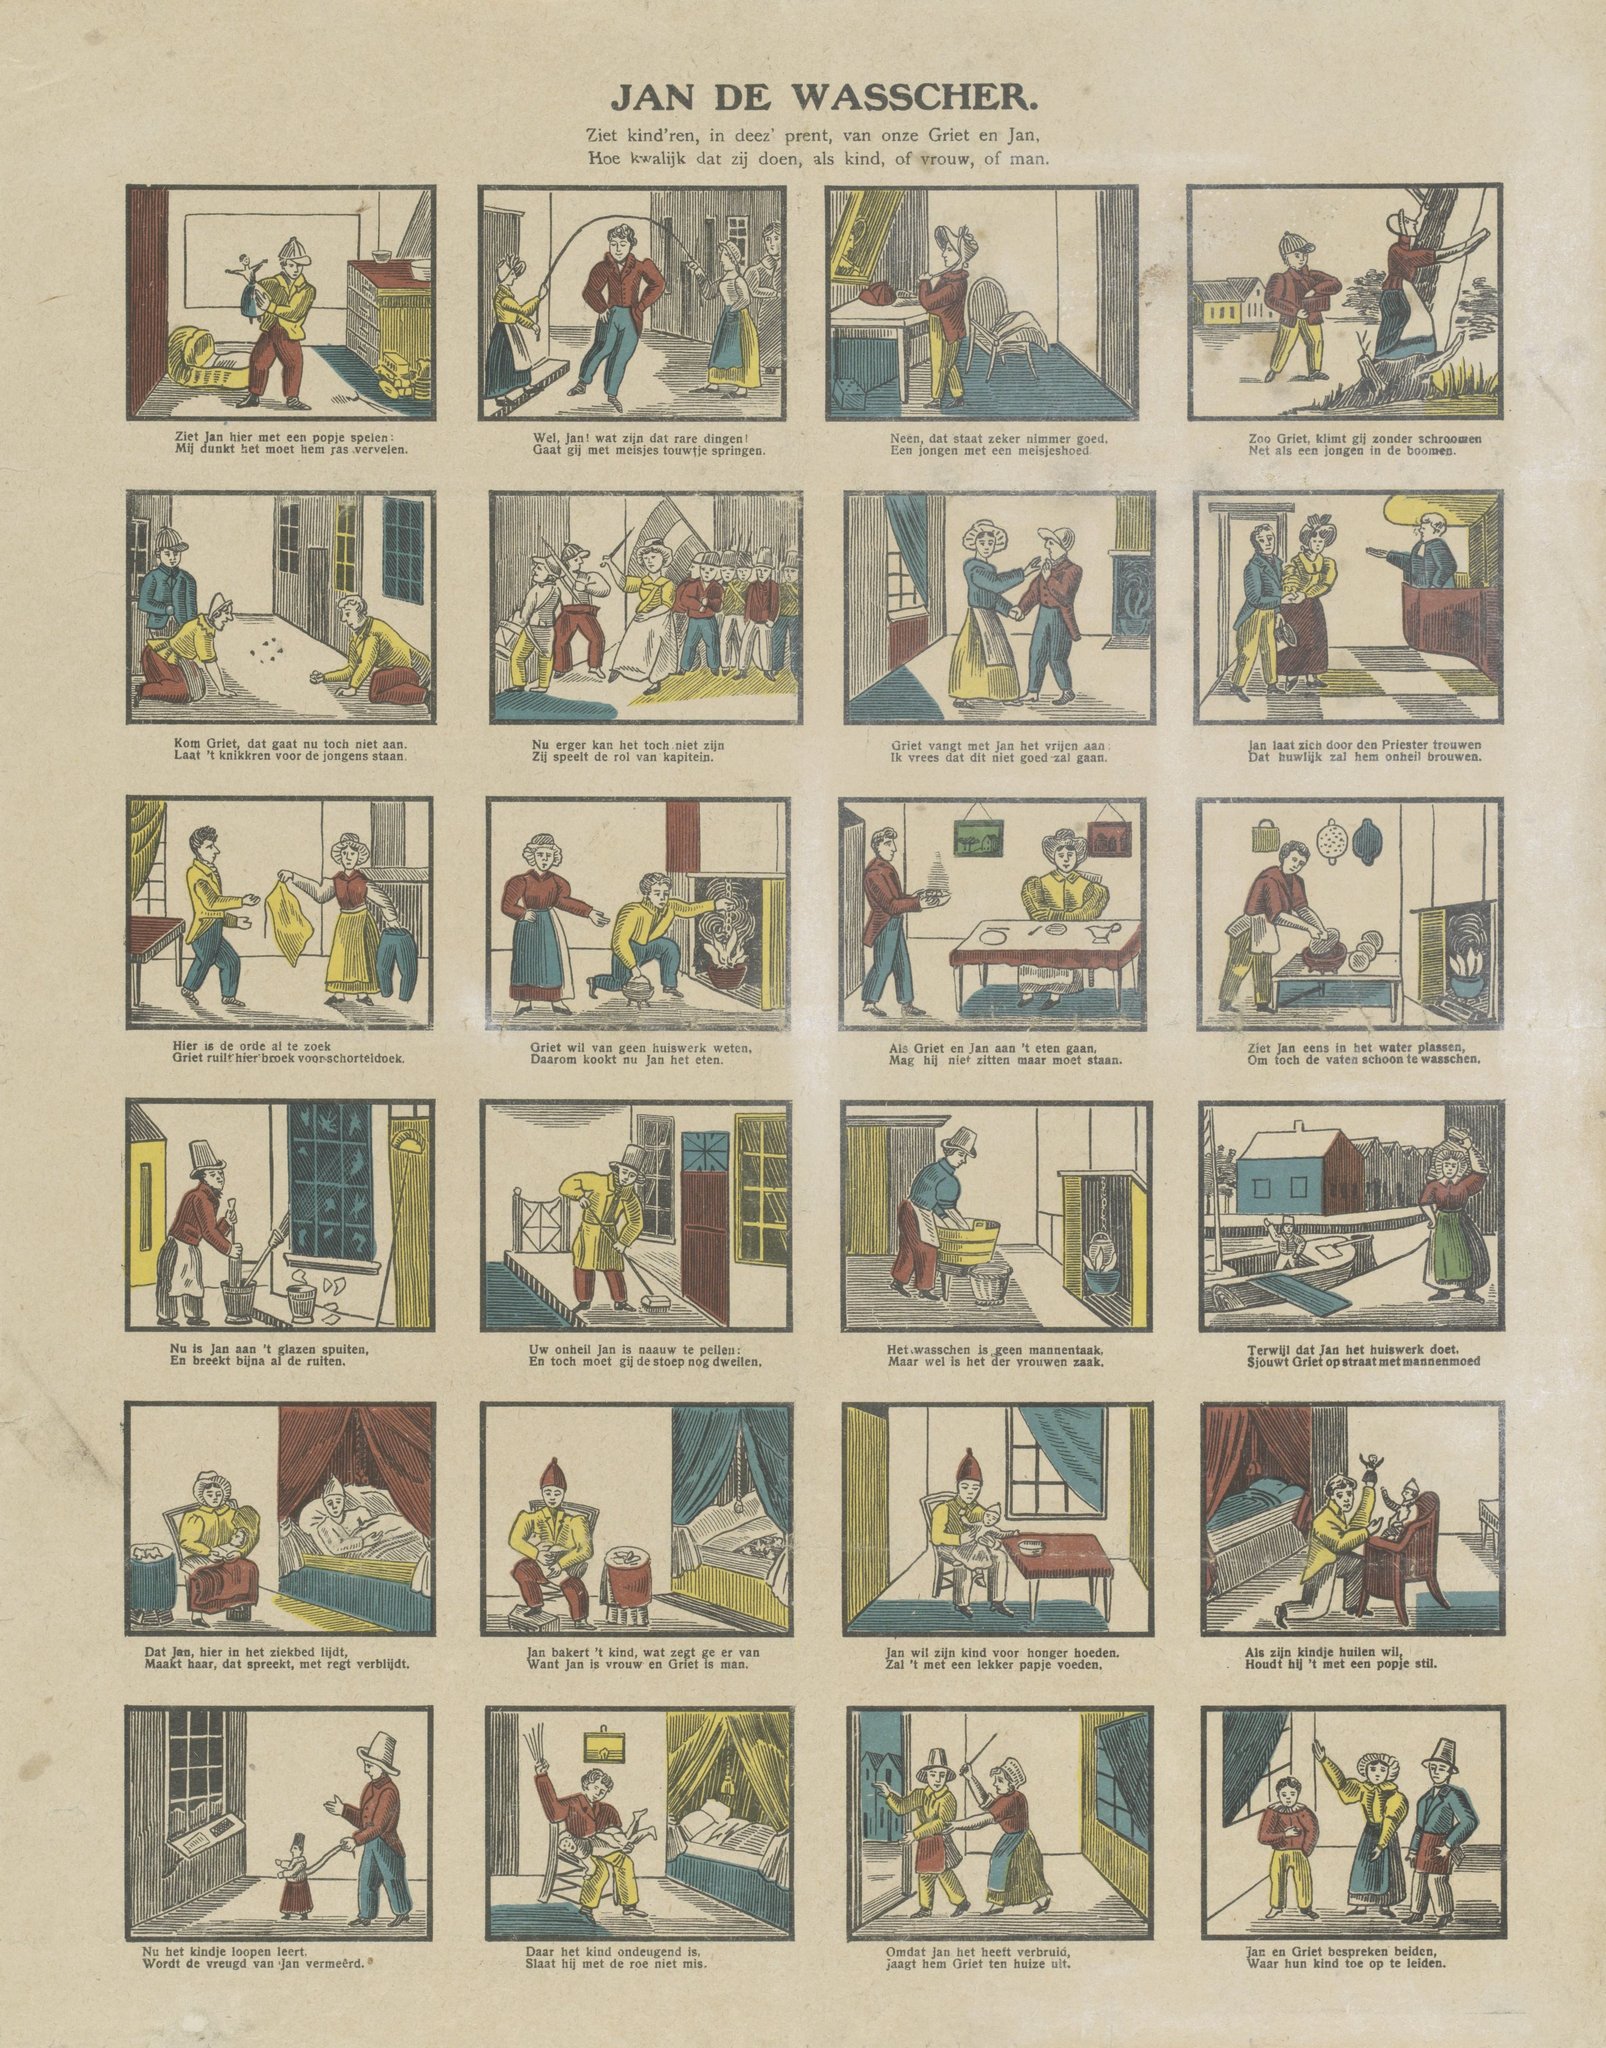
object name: print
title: Jan de Wasscher (John the Washerman)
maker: Anonymous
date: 1700-1899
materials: paper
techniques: colour, letterpress printing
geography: netherlands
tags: hen-pecked husband, 'betty', 'molly' (man who engages in women's work)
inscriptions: collector's mark: Lugt 2760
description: Blad met 24 voorstellingen uit het leven van Jan de Wasser, een man die van zijn vrouw Griet, die de broek aan heeft, al het huishoudelijk werk moet doen. Onder elke voorstelling een tweeregelig vers. Een fondslijst en bestelbiljet in boekdruk op het verso.